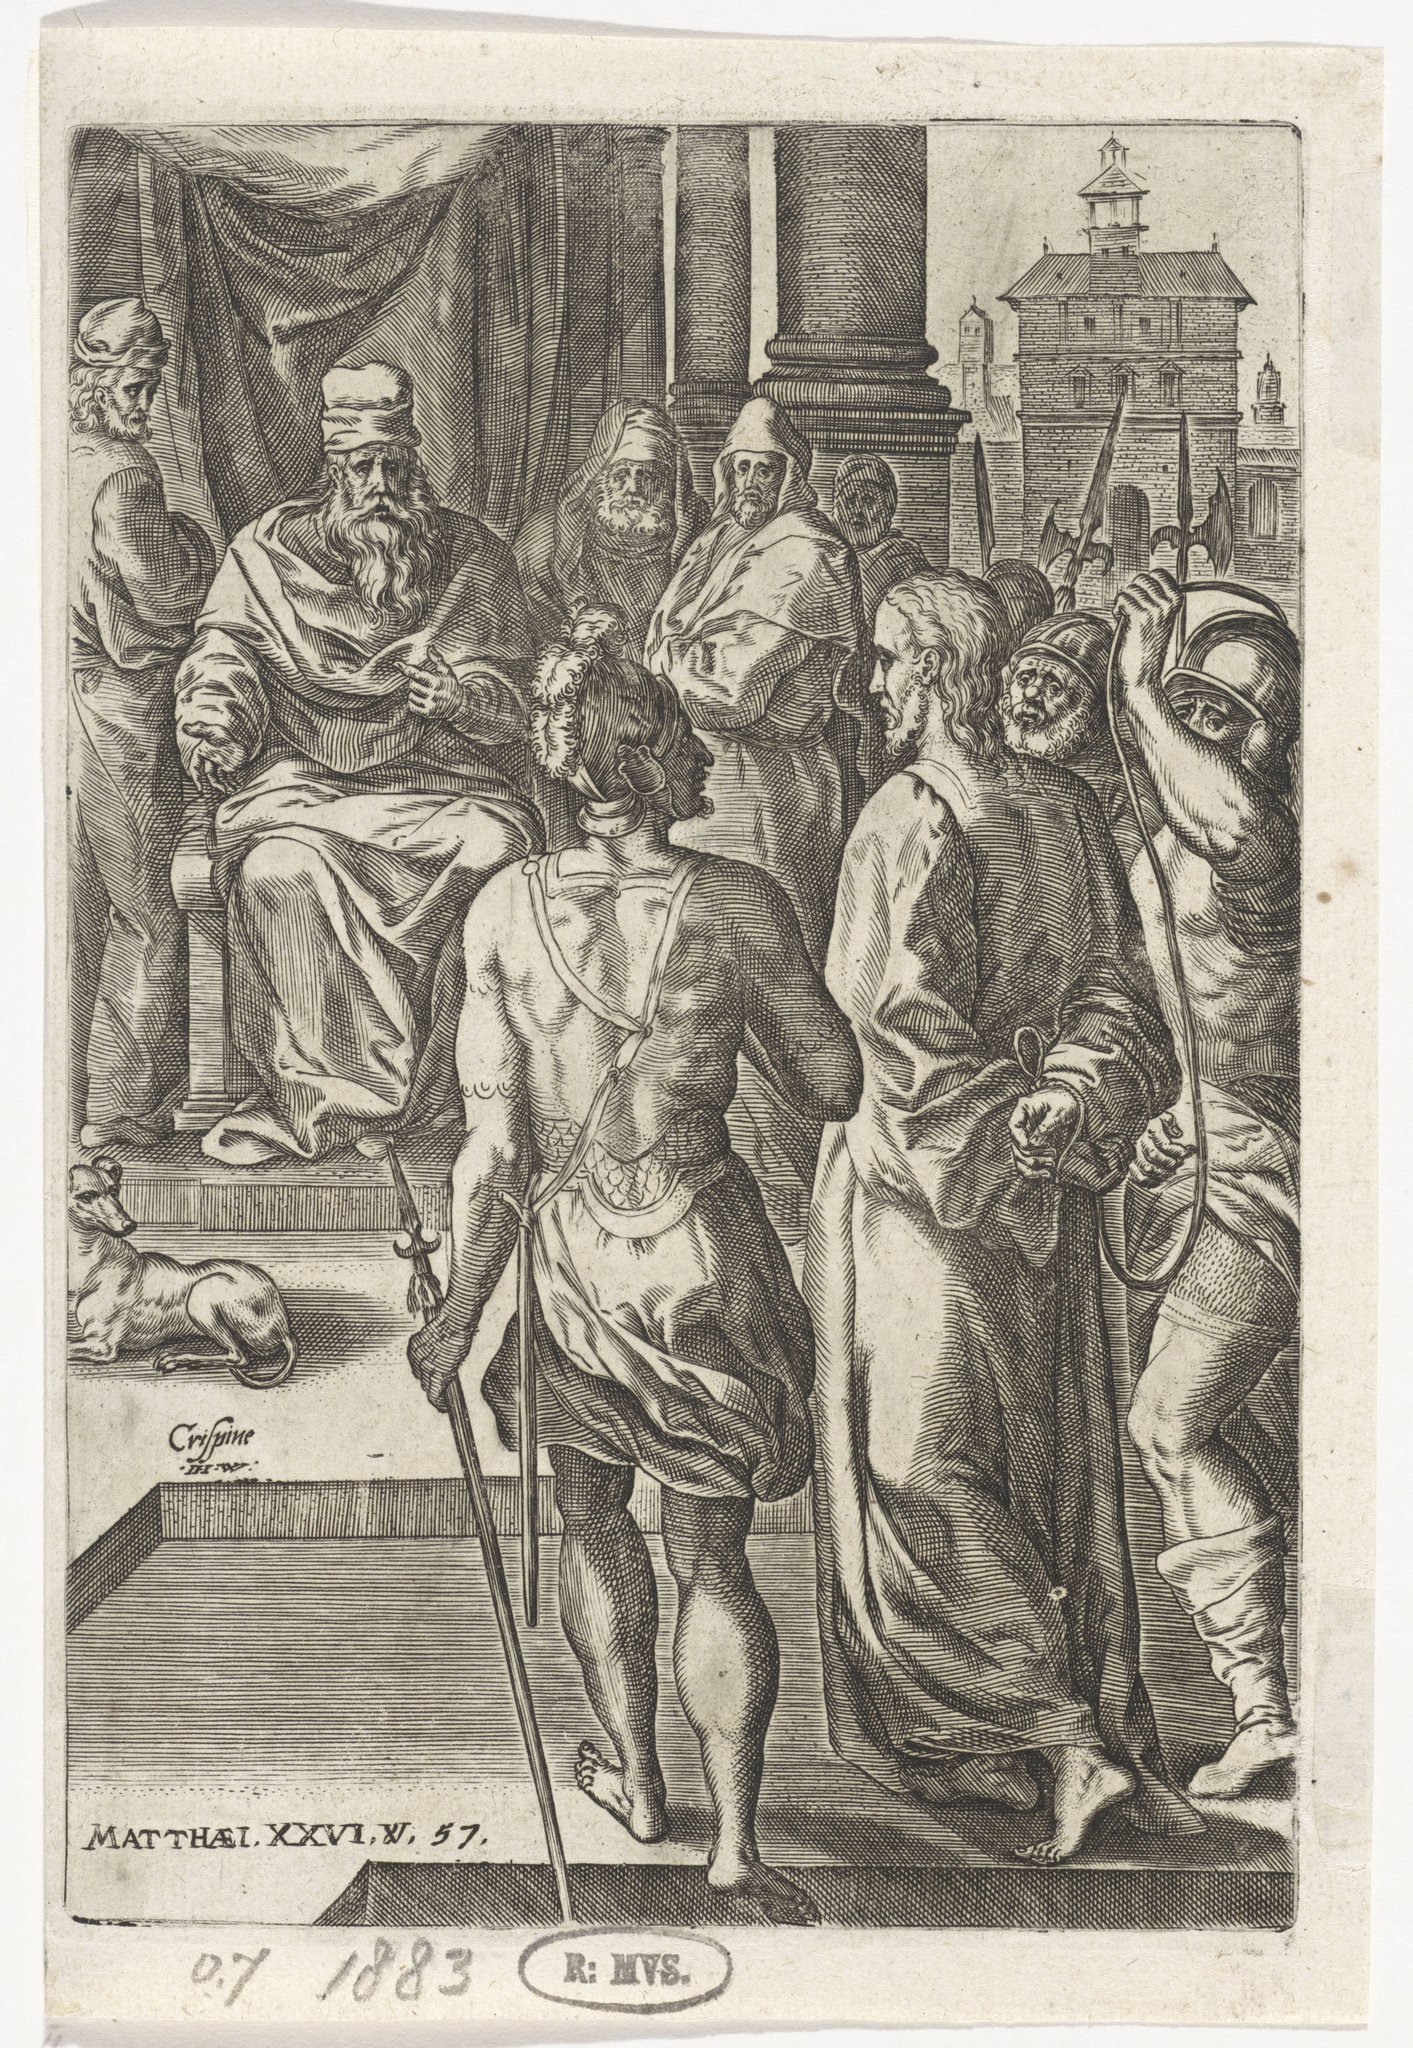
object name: print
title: Christus voor Kajafas geleid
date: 1576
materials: paper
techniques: engraving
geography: antwerp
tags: christ before the sanhedrin with caiaphas as high priest, and possibly annas; maybe a soldier about to strike christ because he keeps silent (matthew 26:57-66; mark 14:53-64; luke 22:54, 22:66-71)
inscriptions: collector's mark: Lugt 2228, collector's mark: Lugt 1337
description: Christus wordt door gewapende soldaten naar koning Herodes gebracht. Herodes ondervraagt Christus, maar die antwoordt hem niet. Hierop bespotten Herodes en zijn soldaten Christus. Linksonder gemarkeerd: "Matthæi.Cap.XXVI.VS.57.".